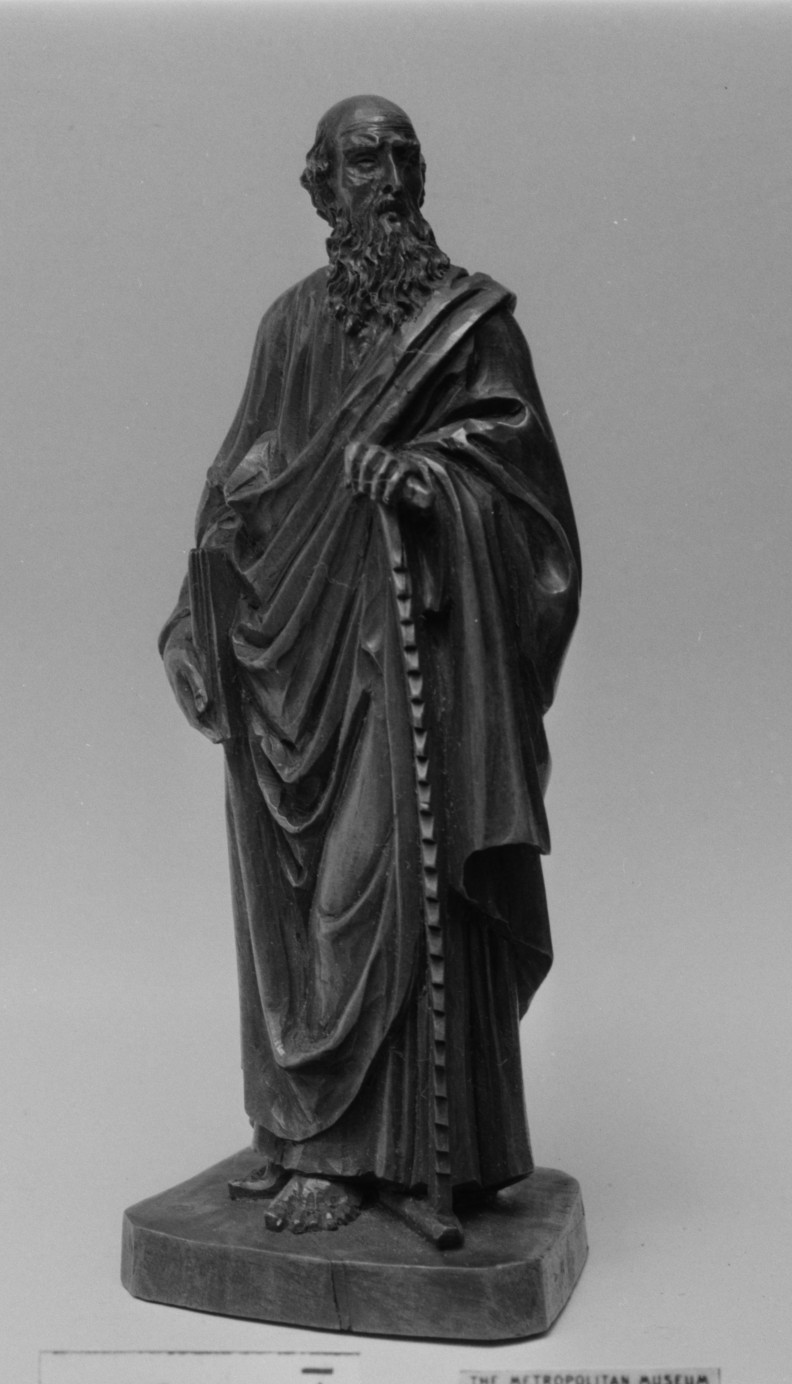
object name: statuette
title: Saint Simon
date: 1501-1600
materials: wood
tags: men,saints